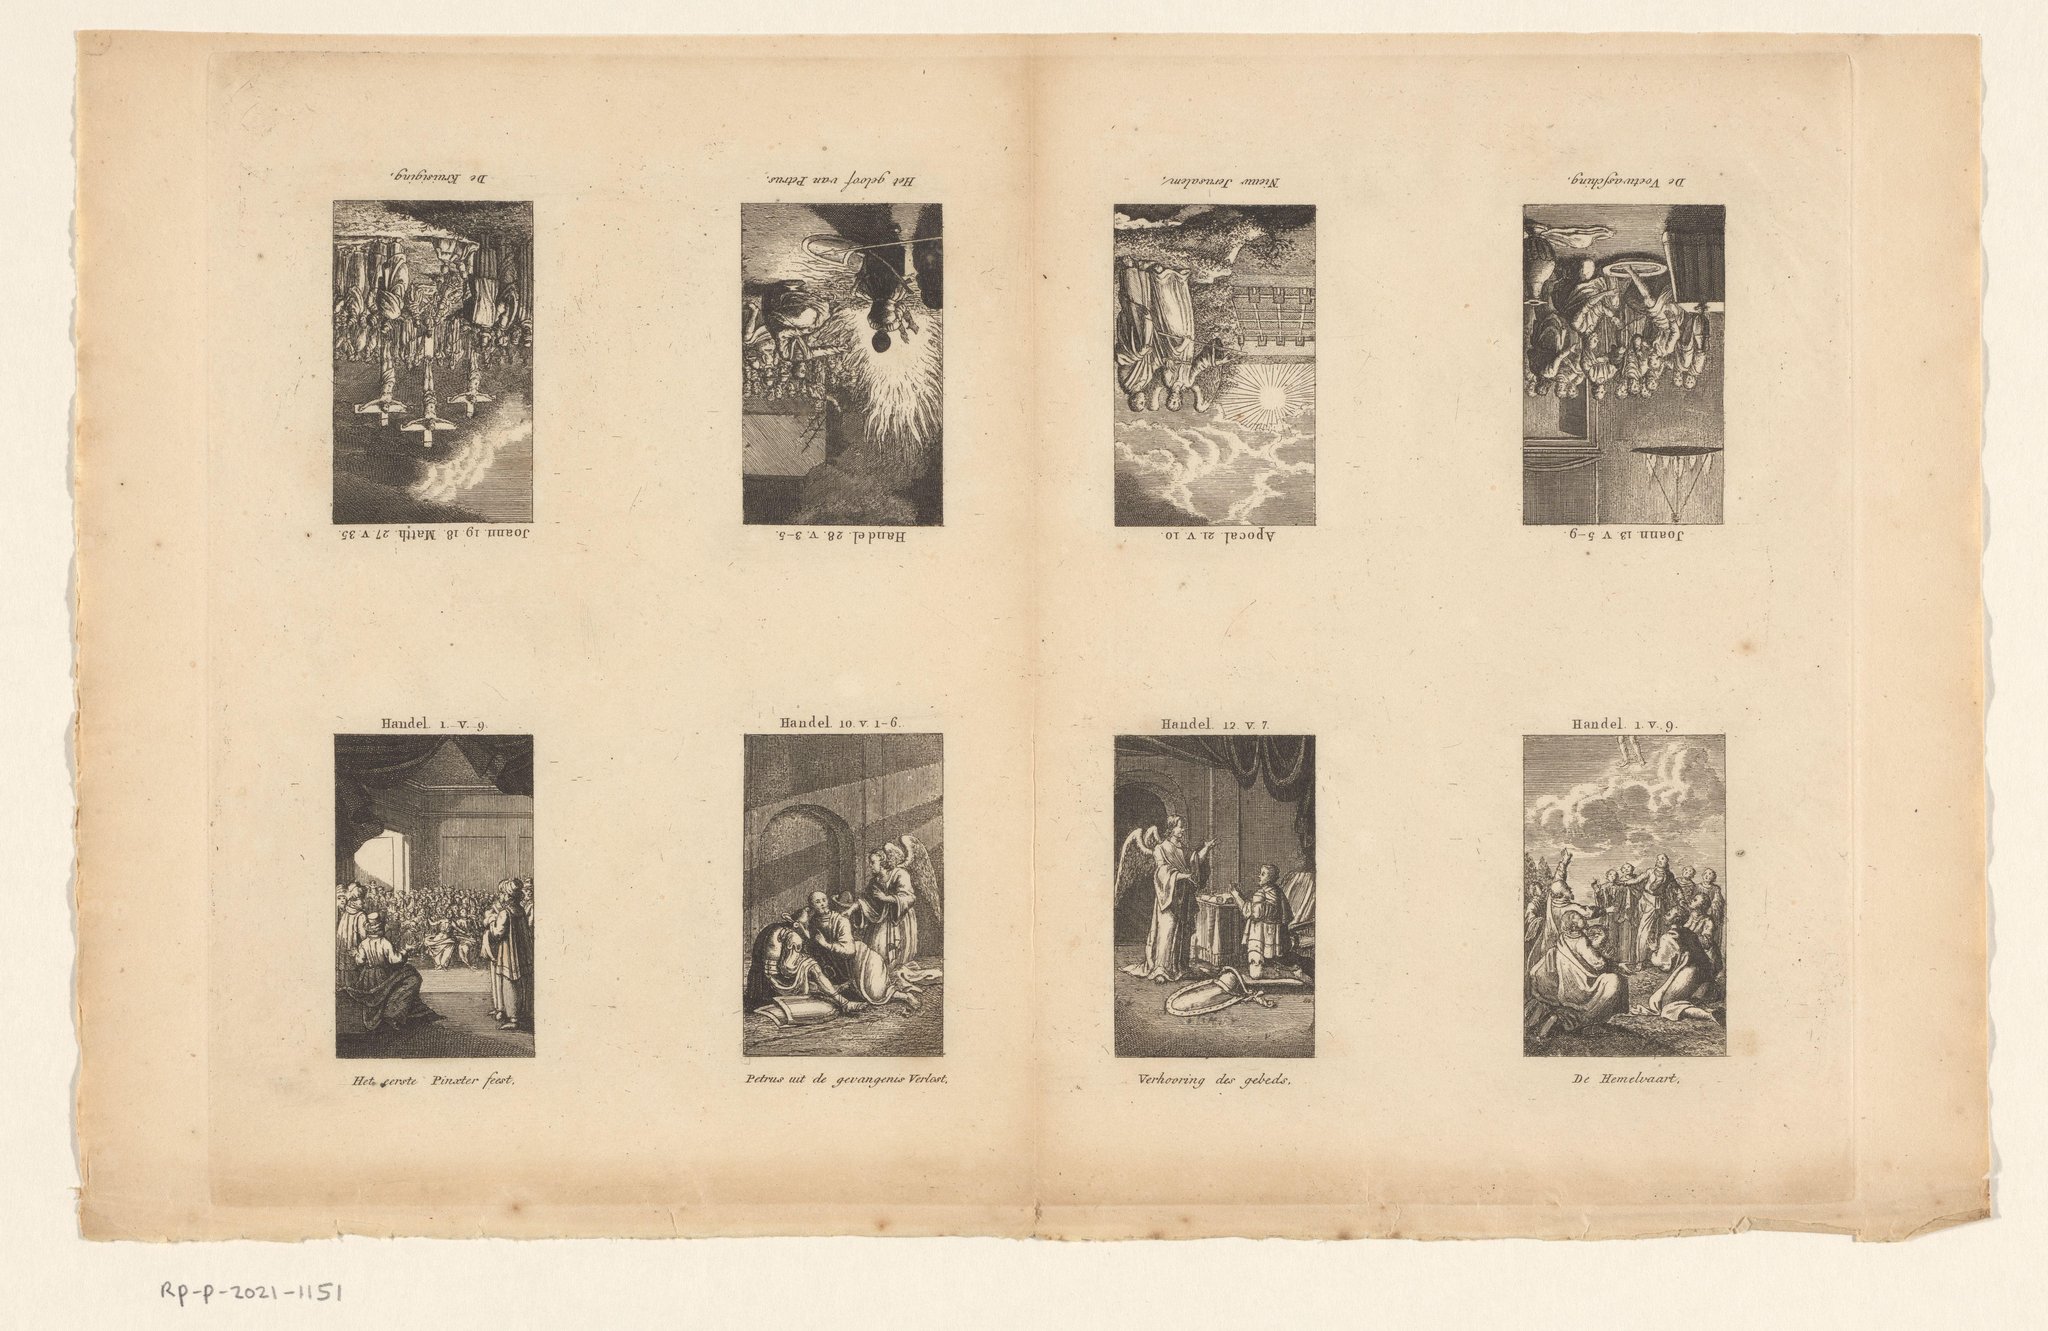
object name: print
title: Acht bijbelvoorstellingen uit Johannes, Matteüs, de Apocalyps en Georg Friedrich Händel's Messiah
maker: Anonymous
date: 1741-1799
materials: paper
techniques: etching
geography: northern netherlands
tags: the new jerusalem, the holy ghost going out from christ, an angel appears, summoning peter to wake up ~ peter in prison, christ washes the feet of the apostles (john 13:1-20), the crucifixion of christ: christ's death on the cross; golgotha (matthew 27:45-58; mark 15:33-45; luke 23:44-52; john 19:25-38), christ almost vanished: only feet visible ~ ascension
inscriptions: collector's mark: Lugt 2228